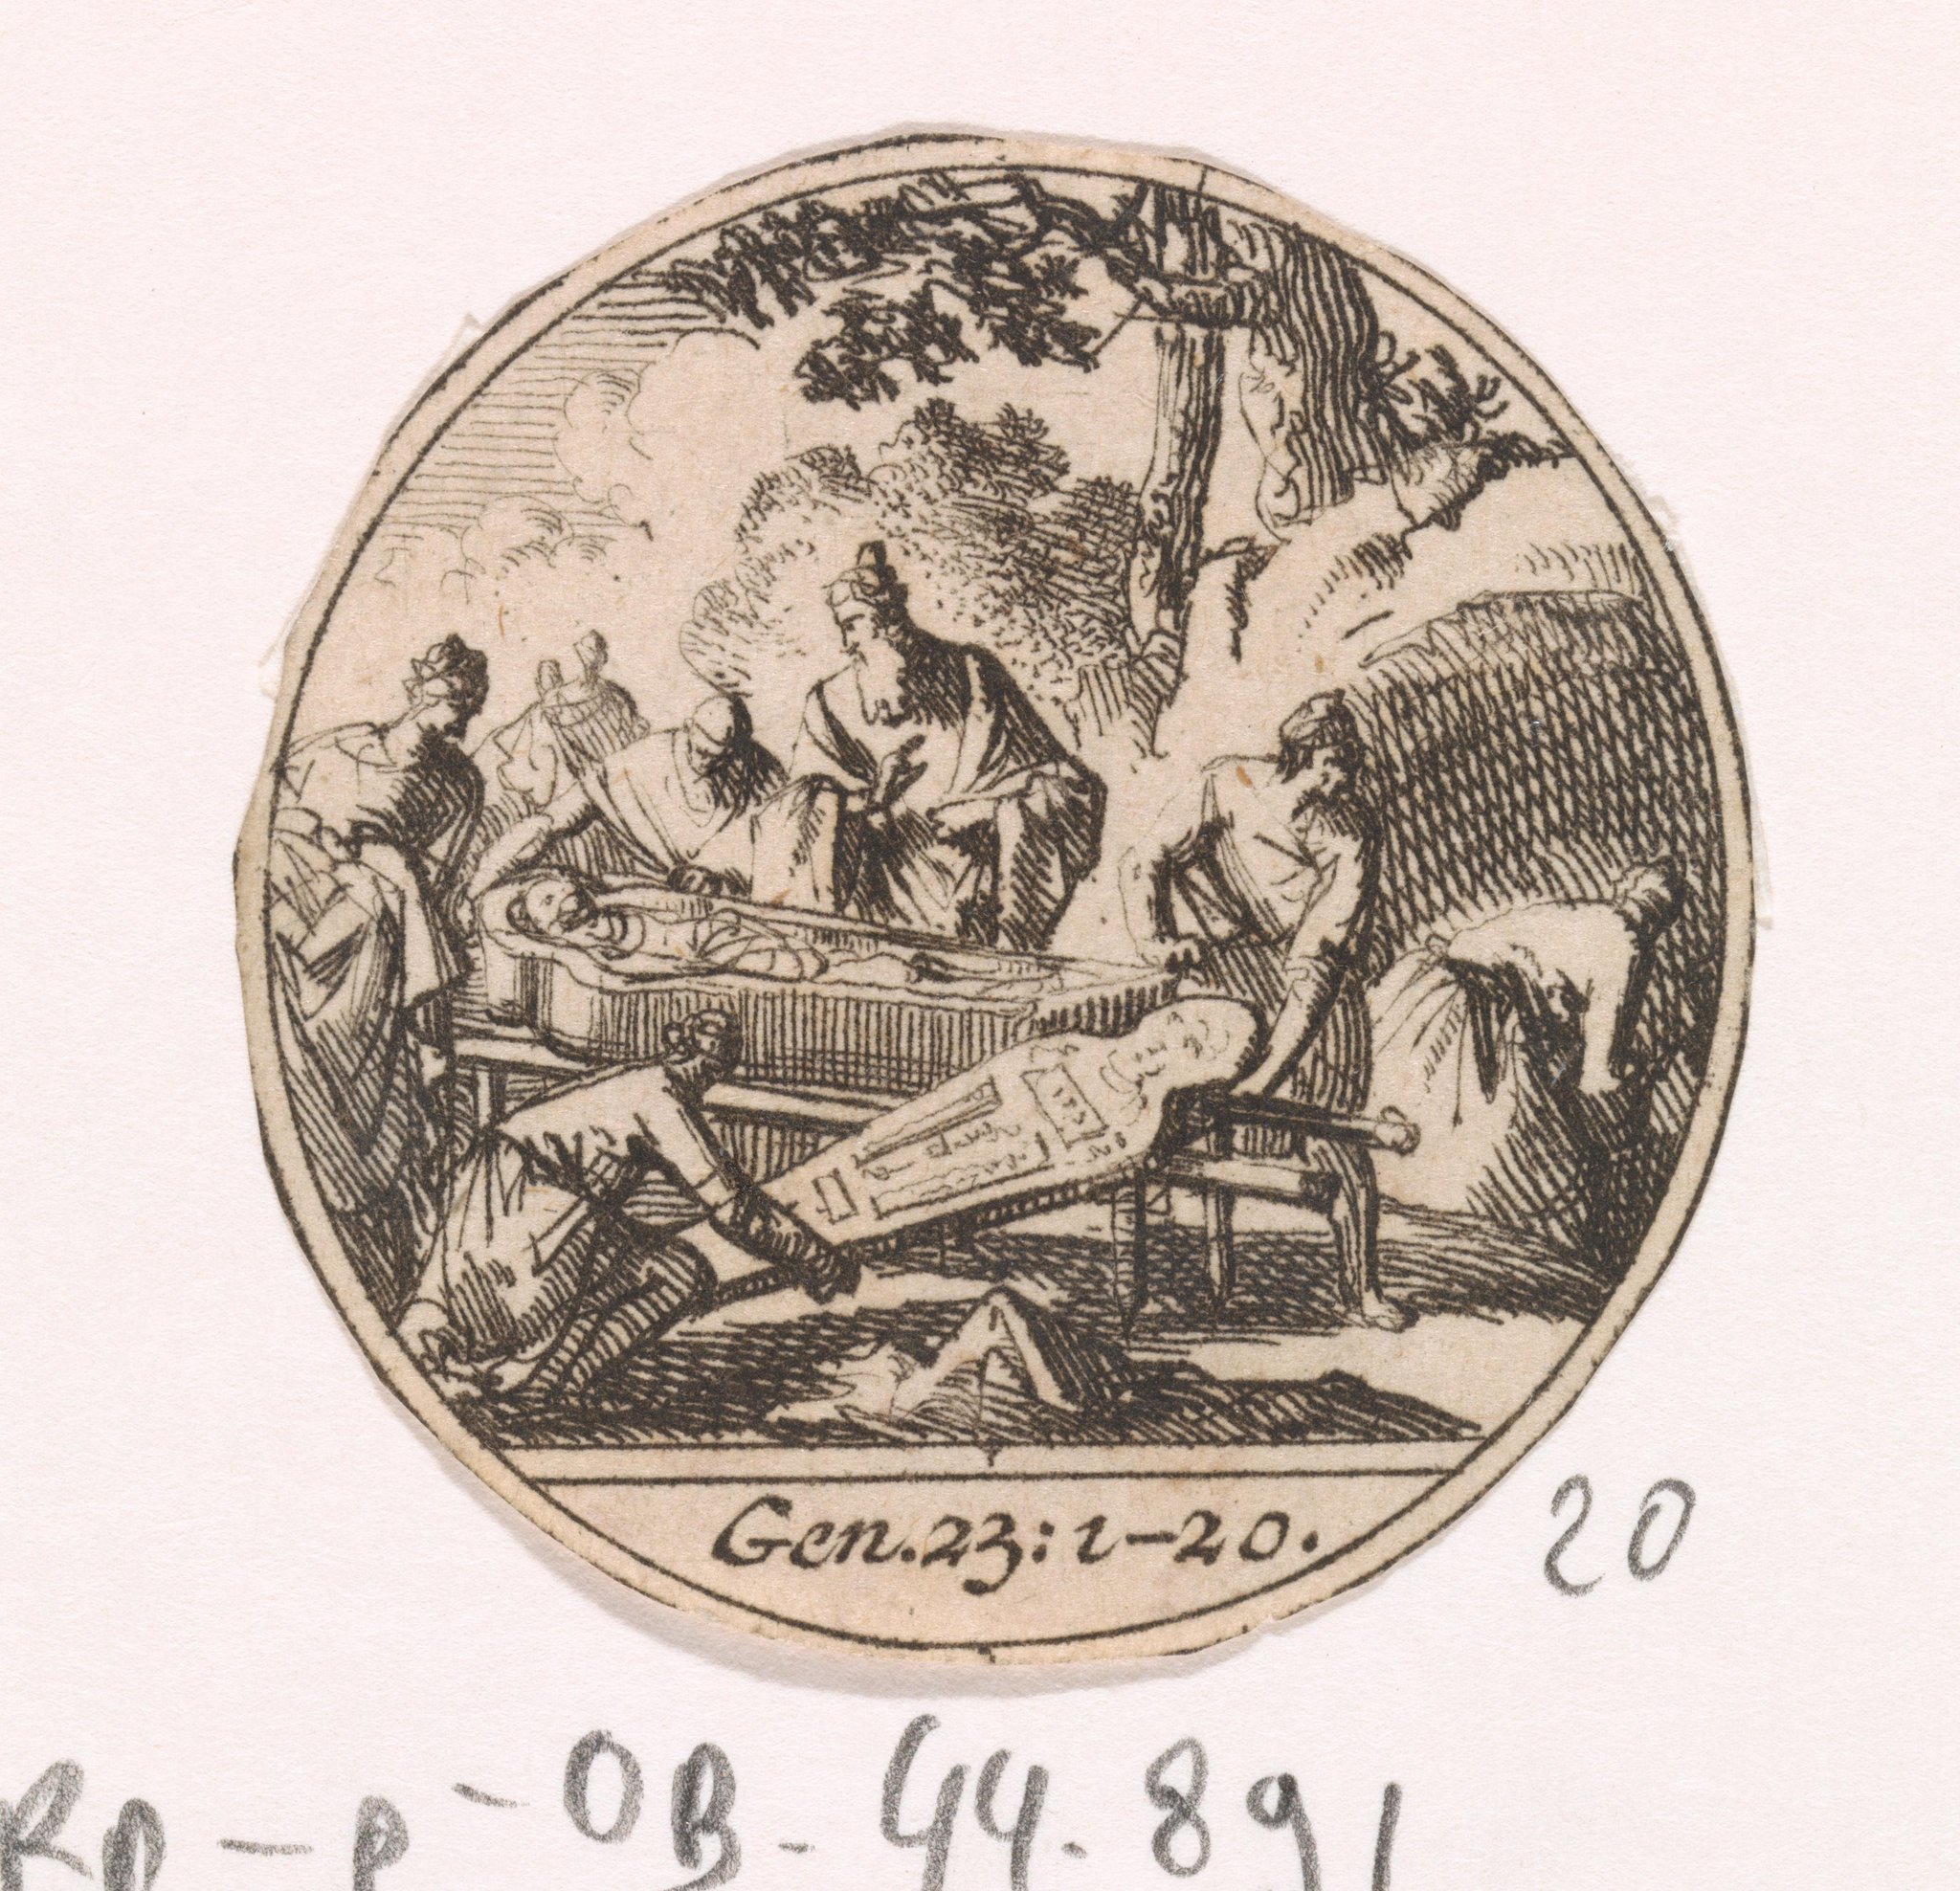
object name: book illustration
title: Begrafenis van Sara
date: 1700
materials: paper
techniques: etching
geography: amsterdam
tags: sarah's burial in the cave of machpelah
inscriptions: collector's mark: Lugt 240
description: Boekillustratie voor Willem Goeree. Mosaize historie der Hebreeuwse kerke. Amsterdam: Willem & David Goeree, 1700.